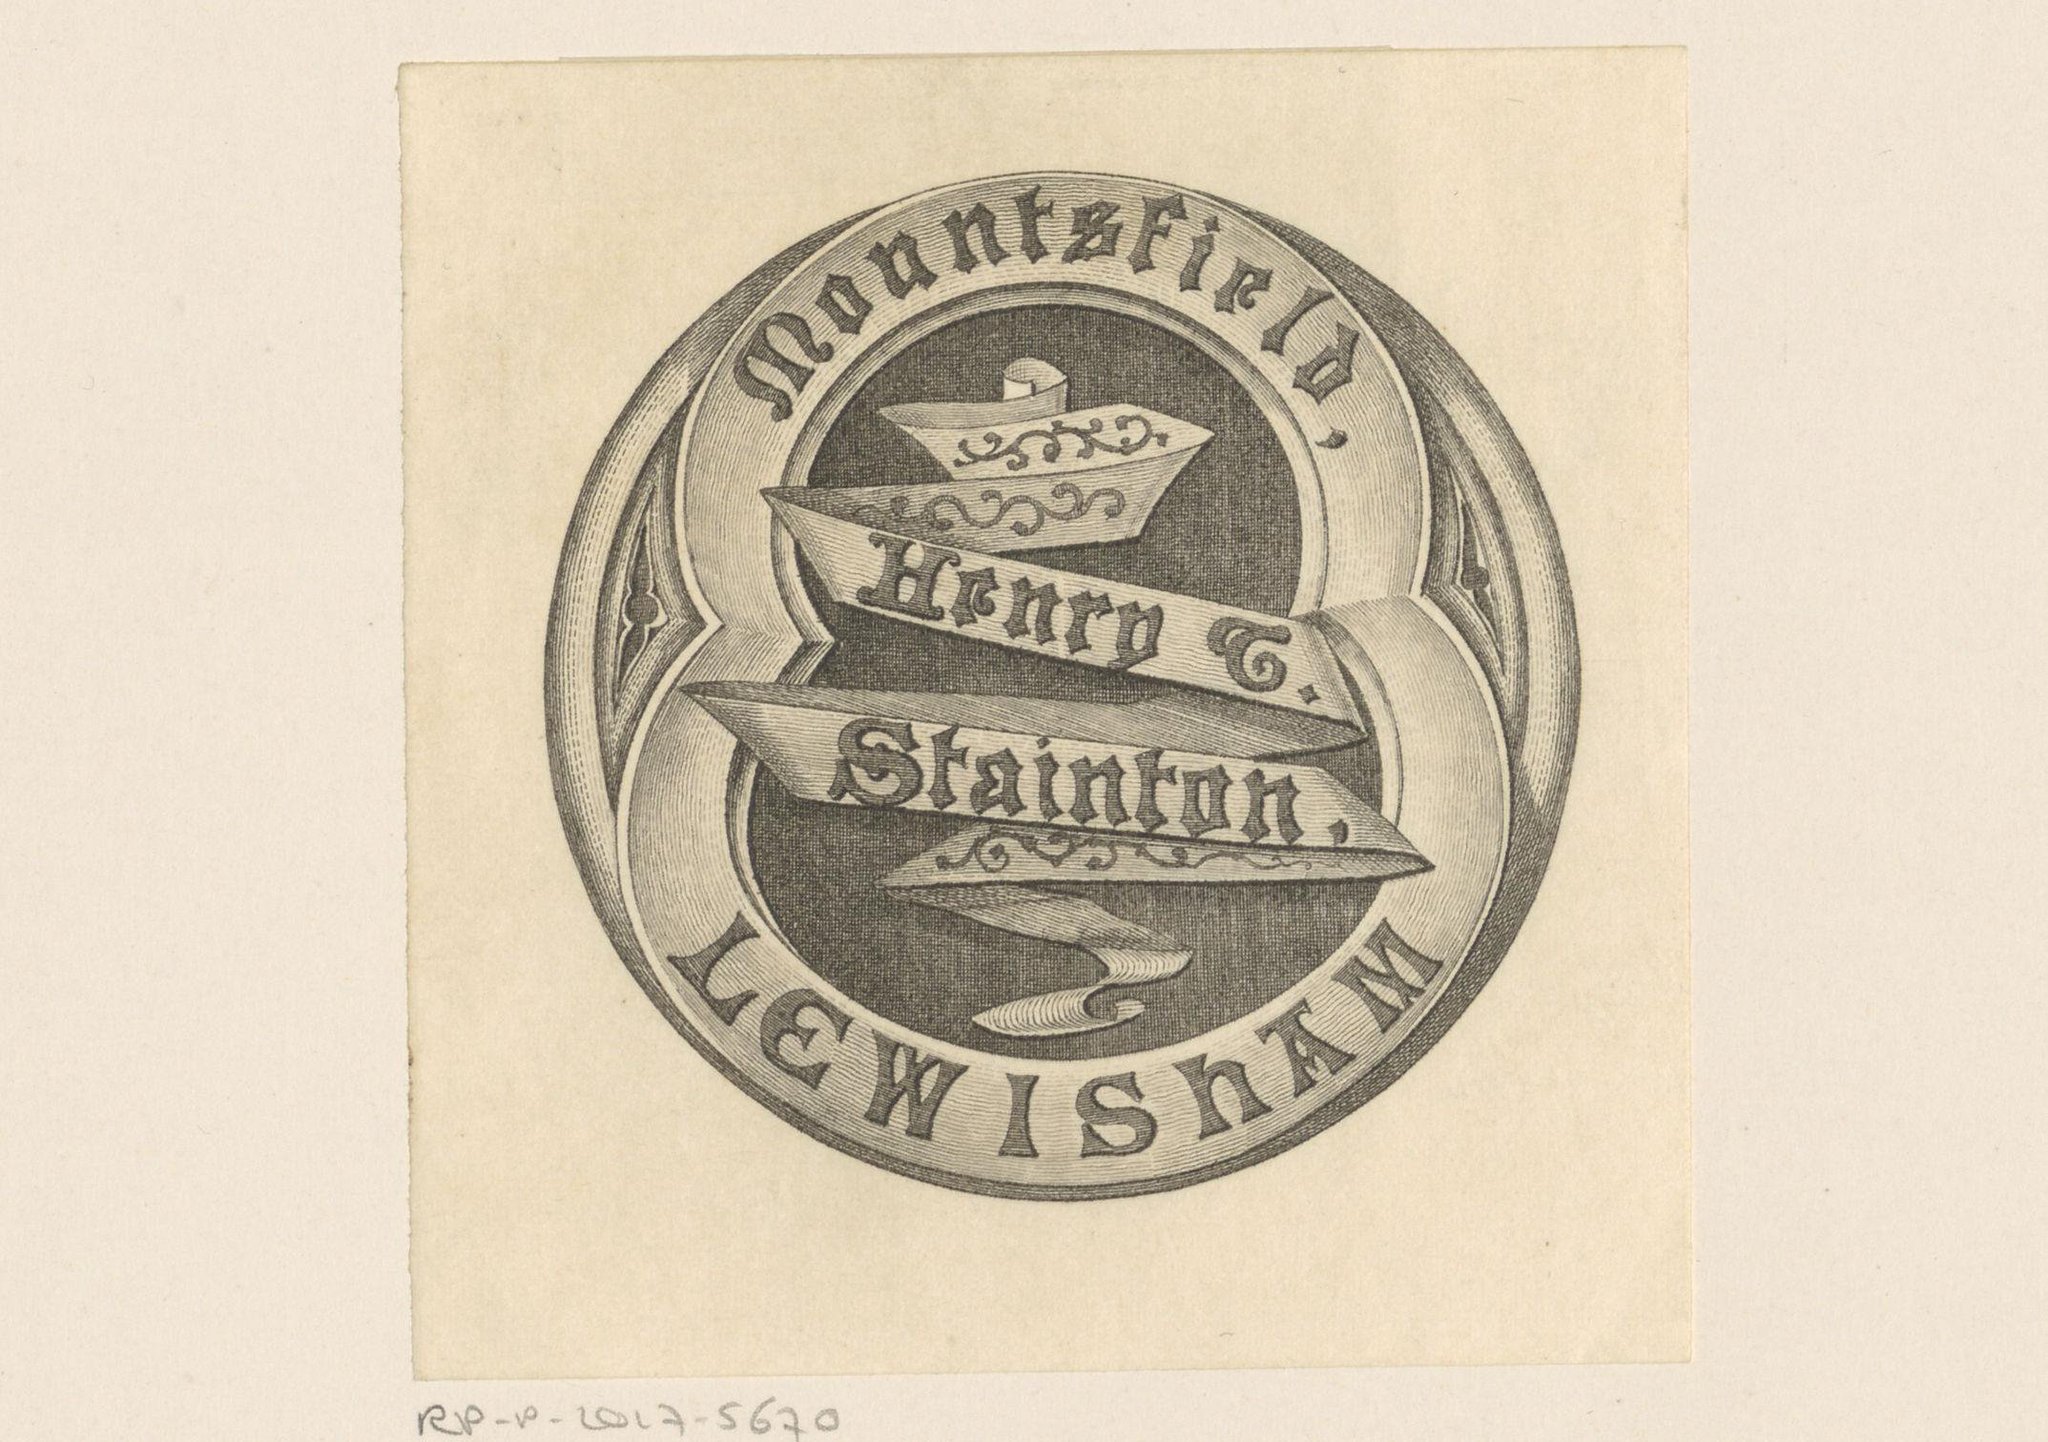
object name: bookplate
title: Ex libris van Henry T. Stainton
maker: Anonymous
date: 1833-1894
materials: paper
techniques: etching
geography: england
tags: henry tibbats stainton